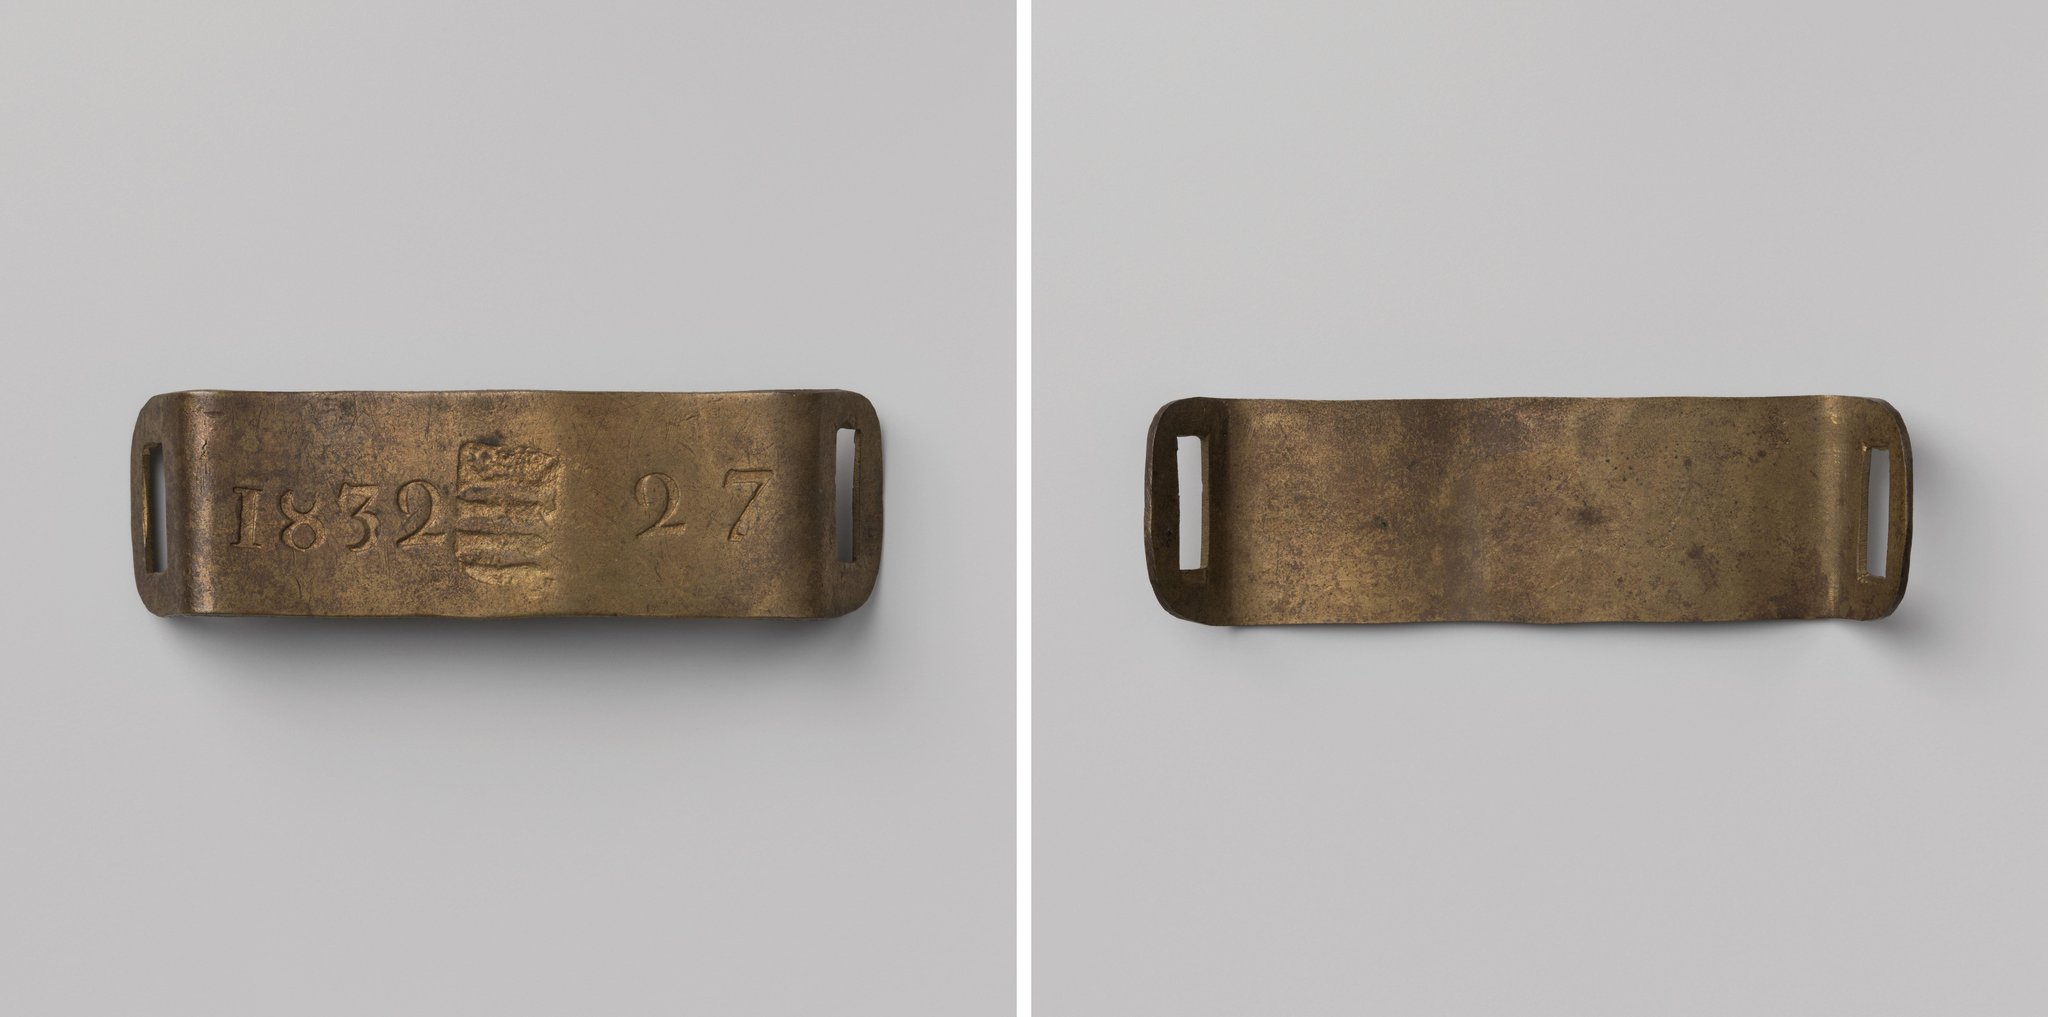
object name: tax token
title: Stad Enkhuizen, loodje met no. 27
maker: Anonymous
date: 1832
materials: brass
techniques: striking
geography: enkhuizen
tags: enkhuizen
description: eenzijdig, staafvormig loodje met omgebogen uiteinden met daarin rechthoekige uitsparing. Voorzijde: wapenschild met ter linkerzijde jaartal, ter rechterzijde cijfer 27. Keerzijde: blanco